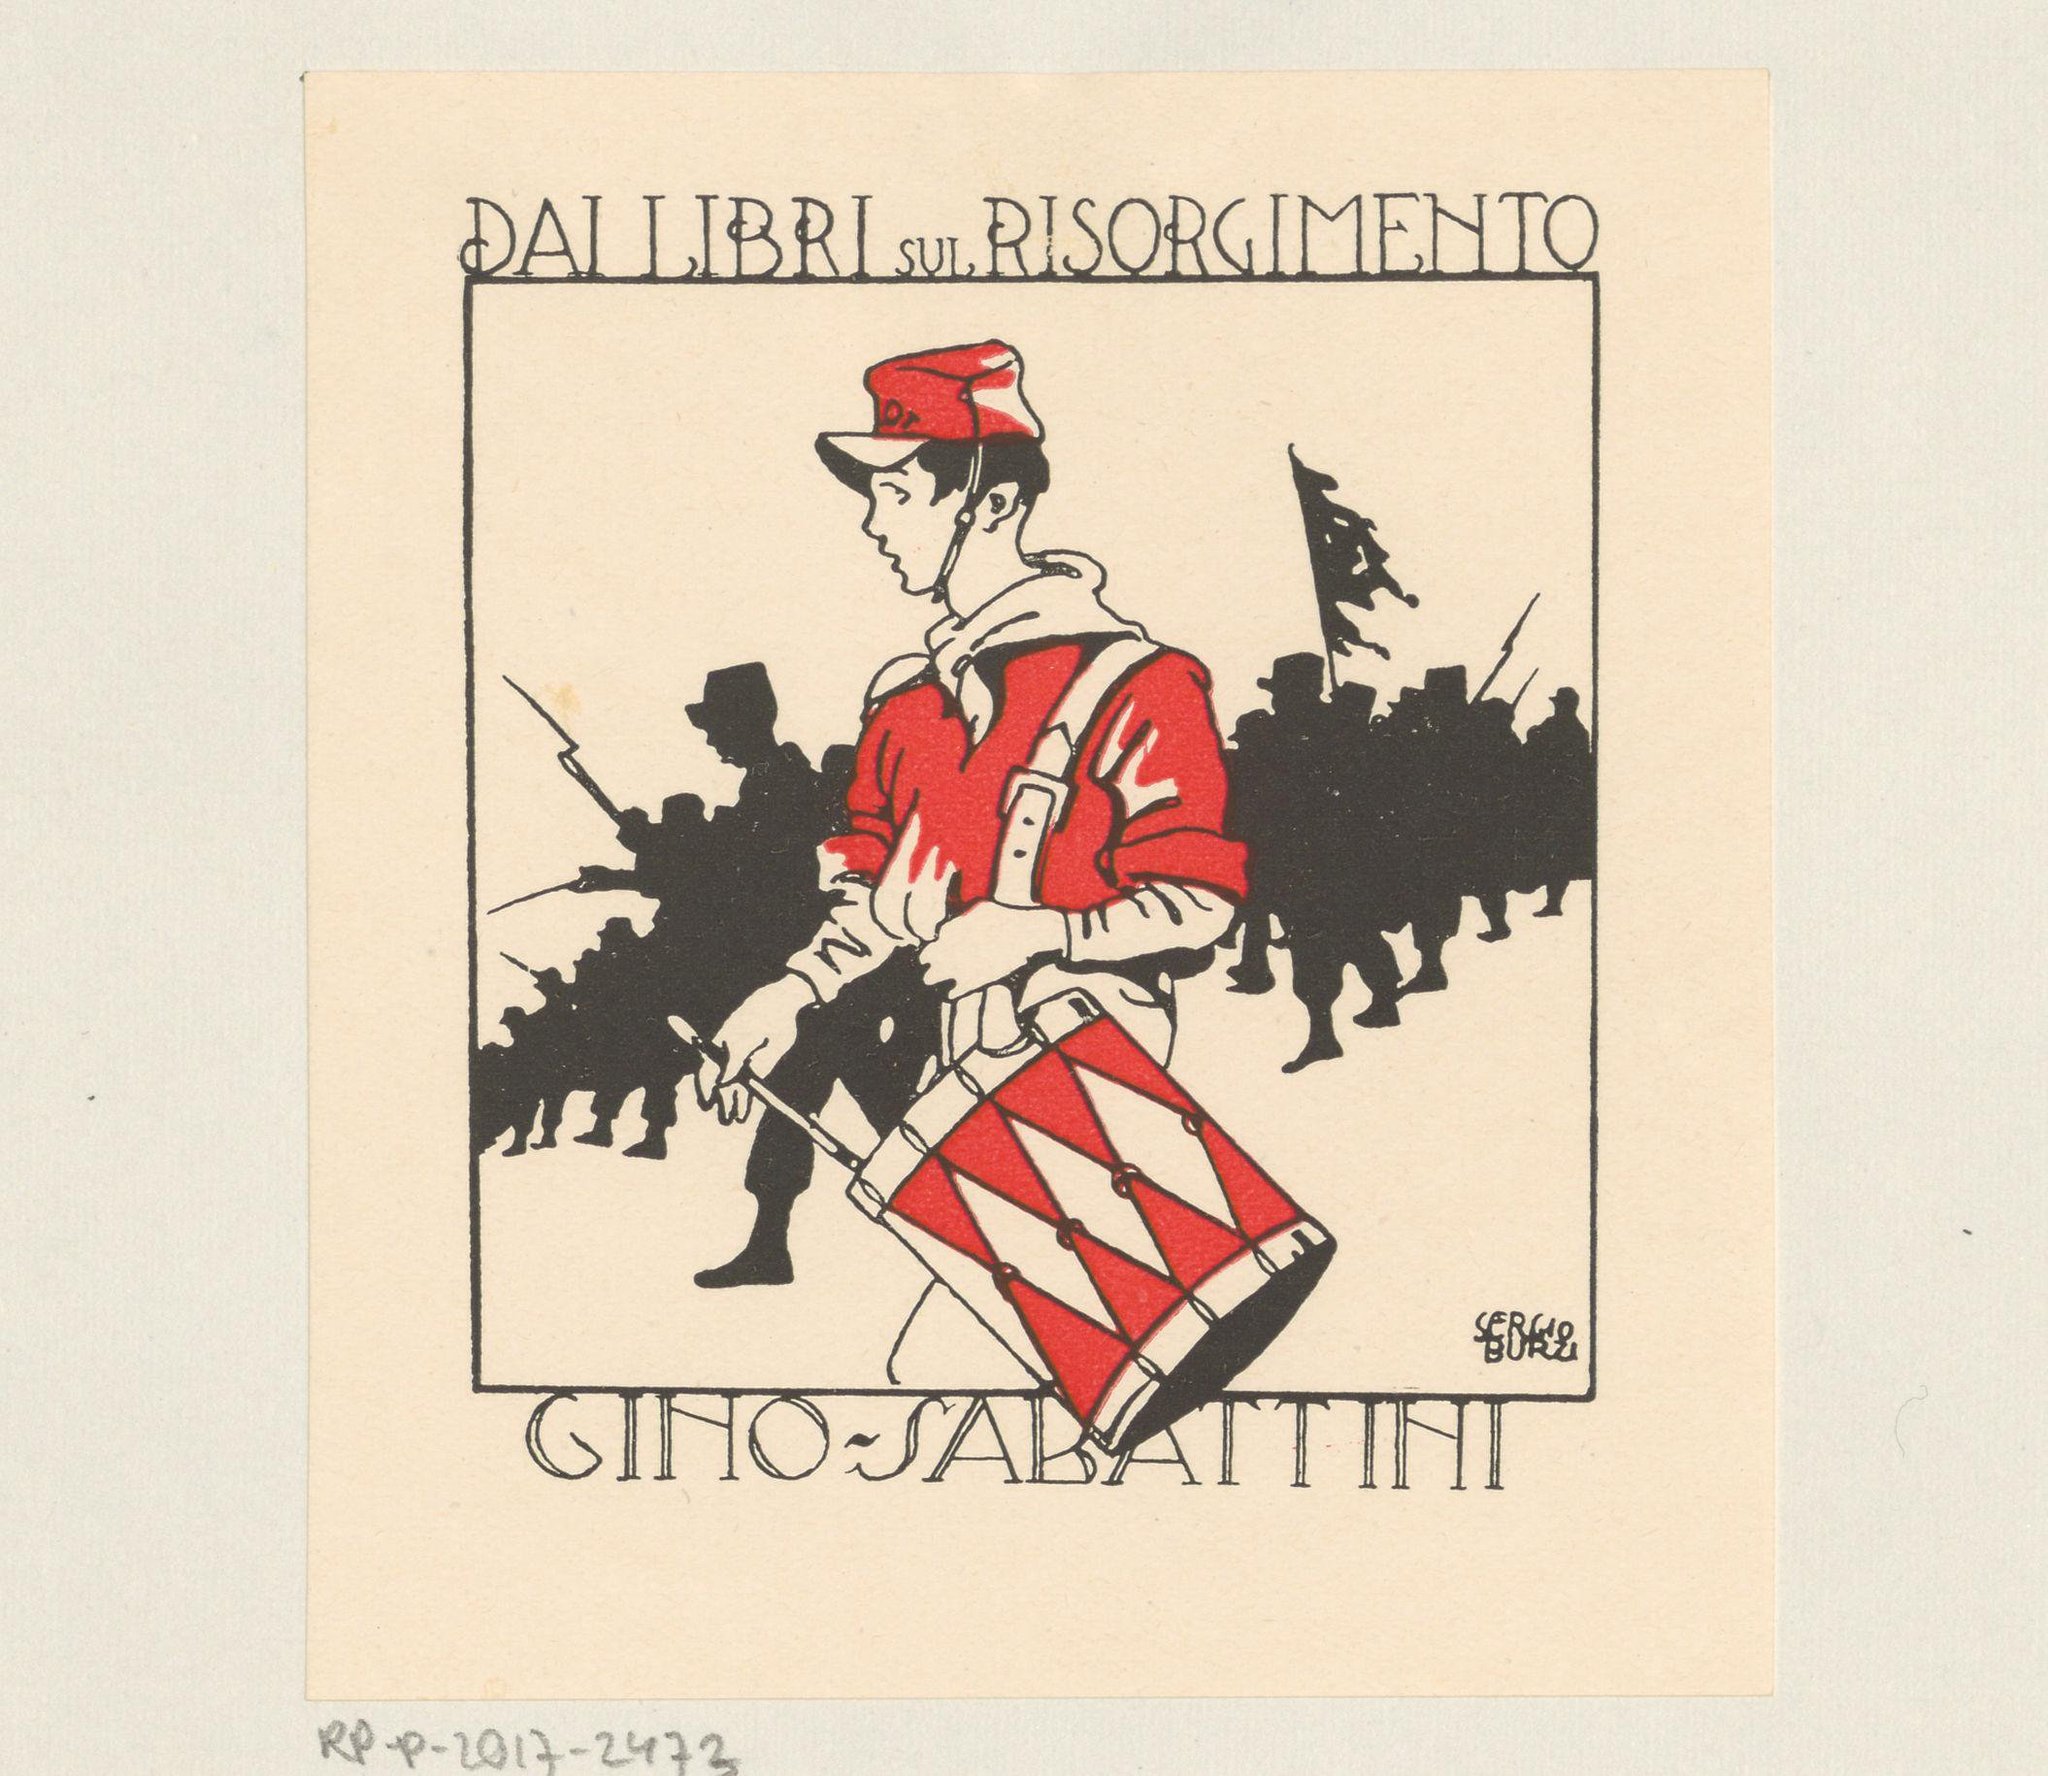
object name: bookplate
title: Ex libris van Gino Sabattini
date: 1940-1950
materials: paper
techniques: printing block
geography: bologna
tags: gino sabattini, drum (musical instrument), warfare; military affairs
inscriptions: inscription: ‘S. Burzi - Bologna - 1949 (?)’